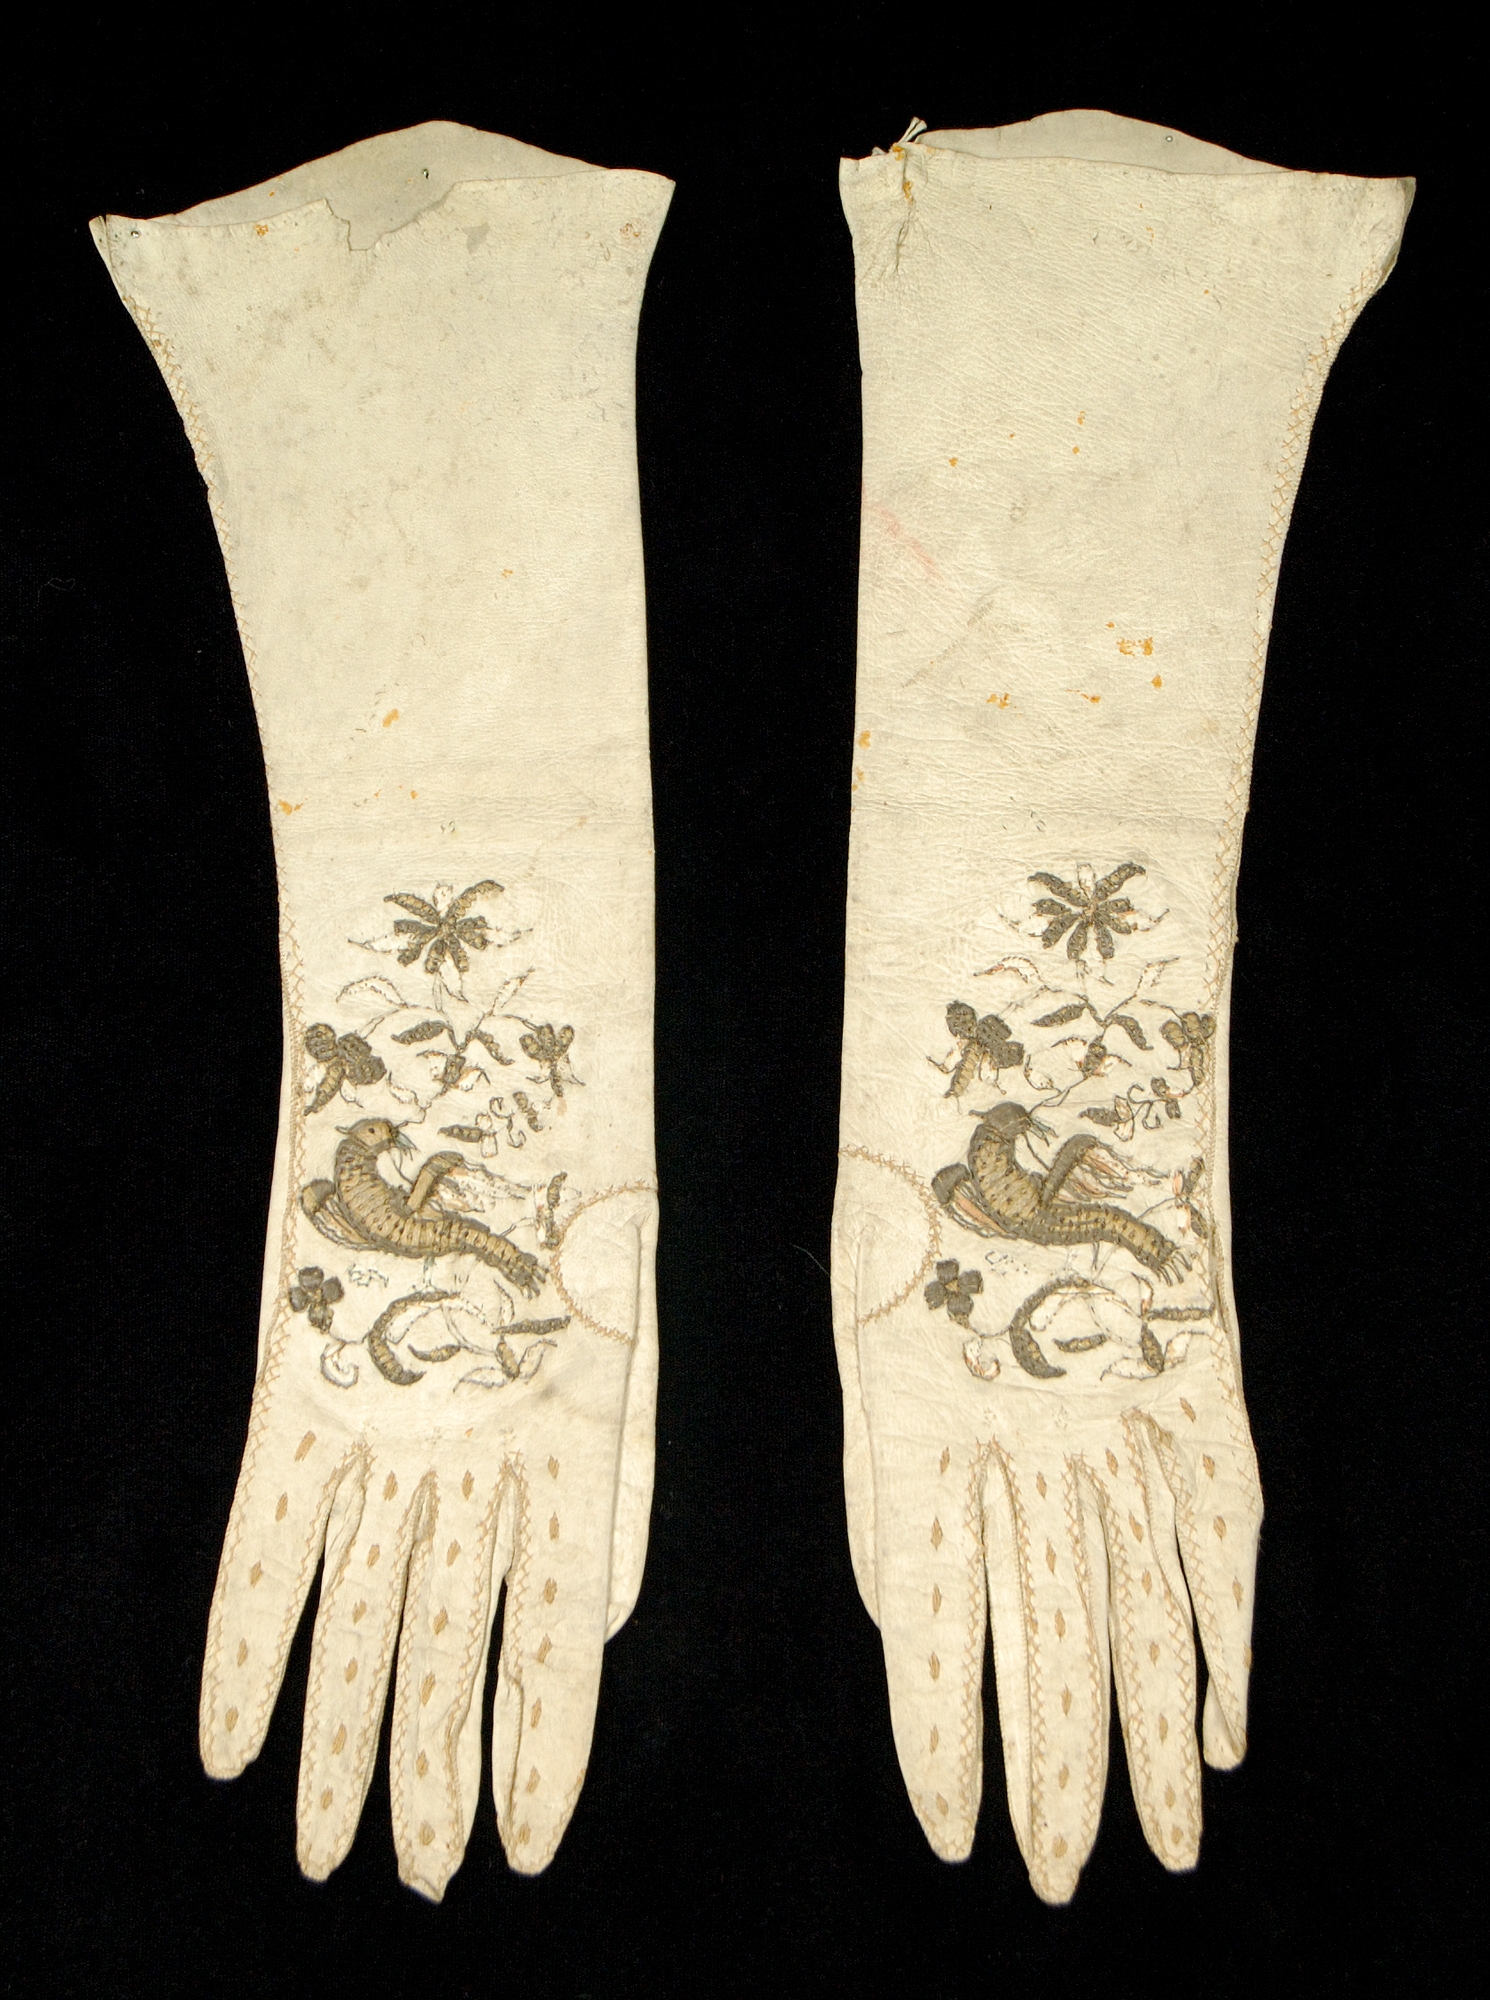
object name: glove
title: Gloves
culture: british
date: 1701-1733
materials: leather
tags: birds